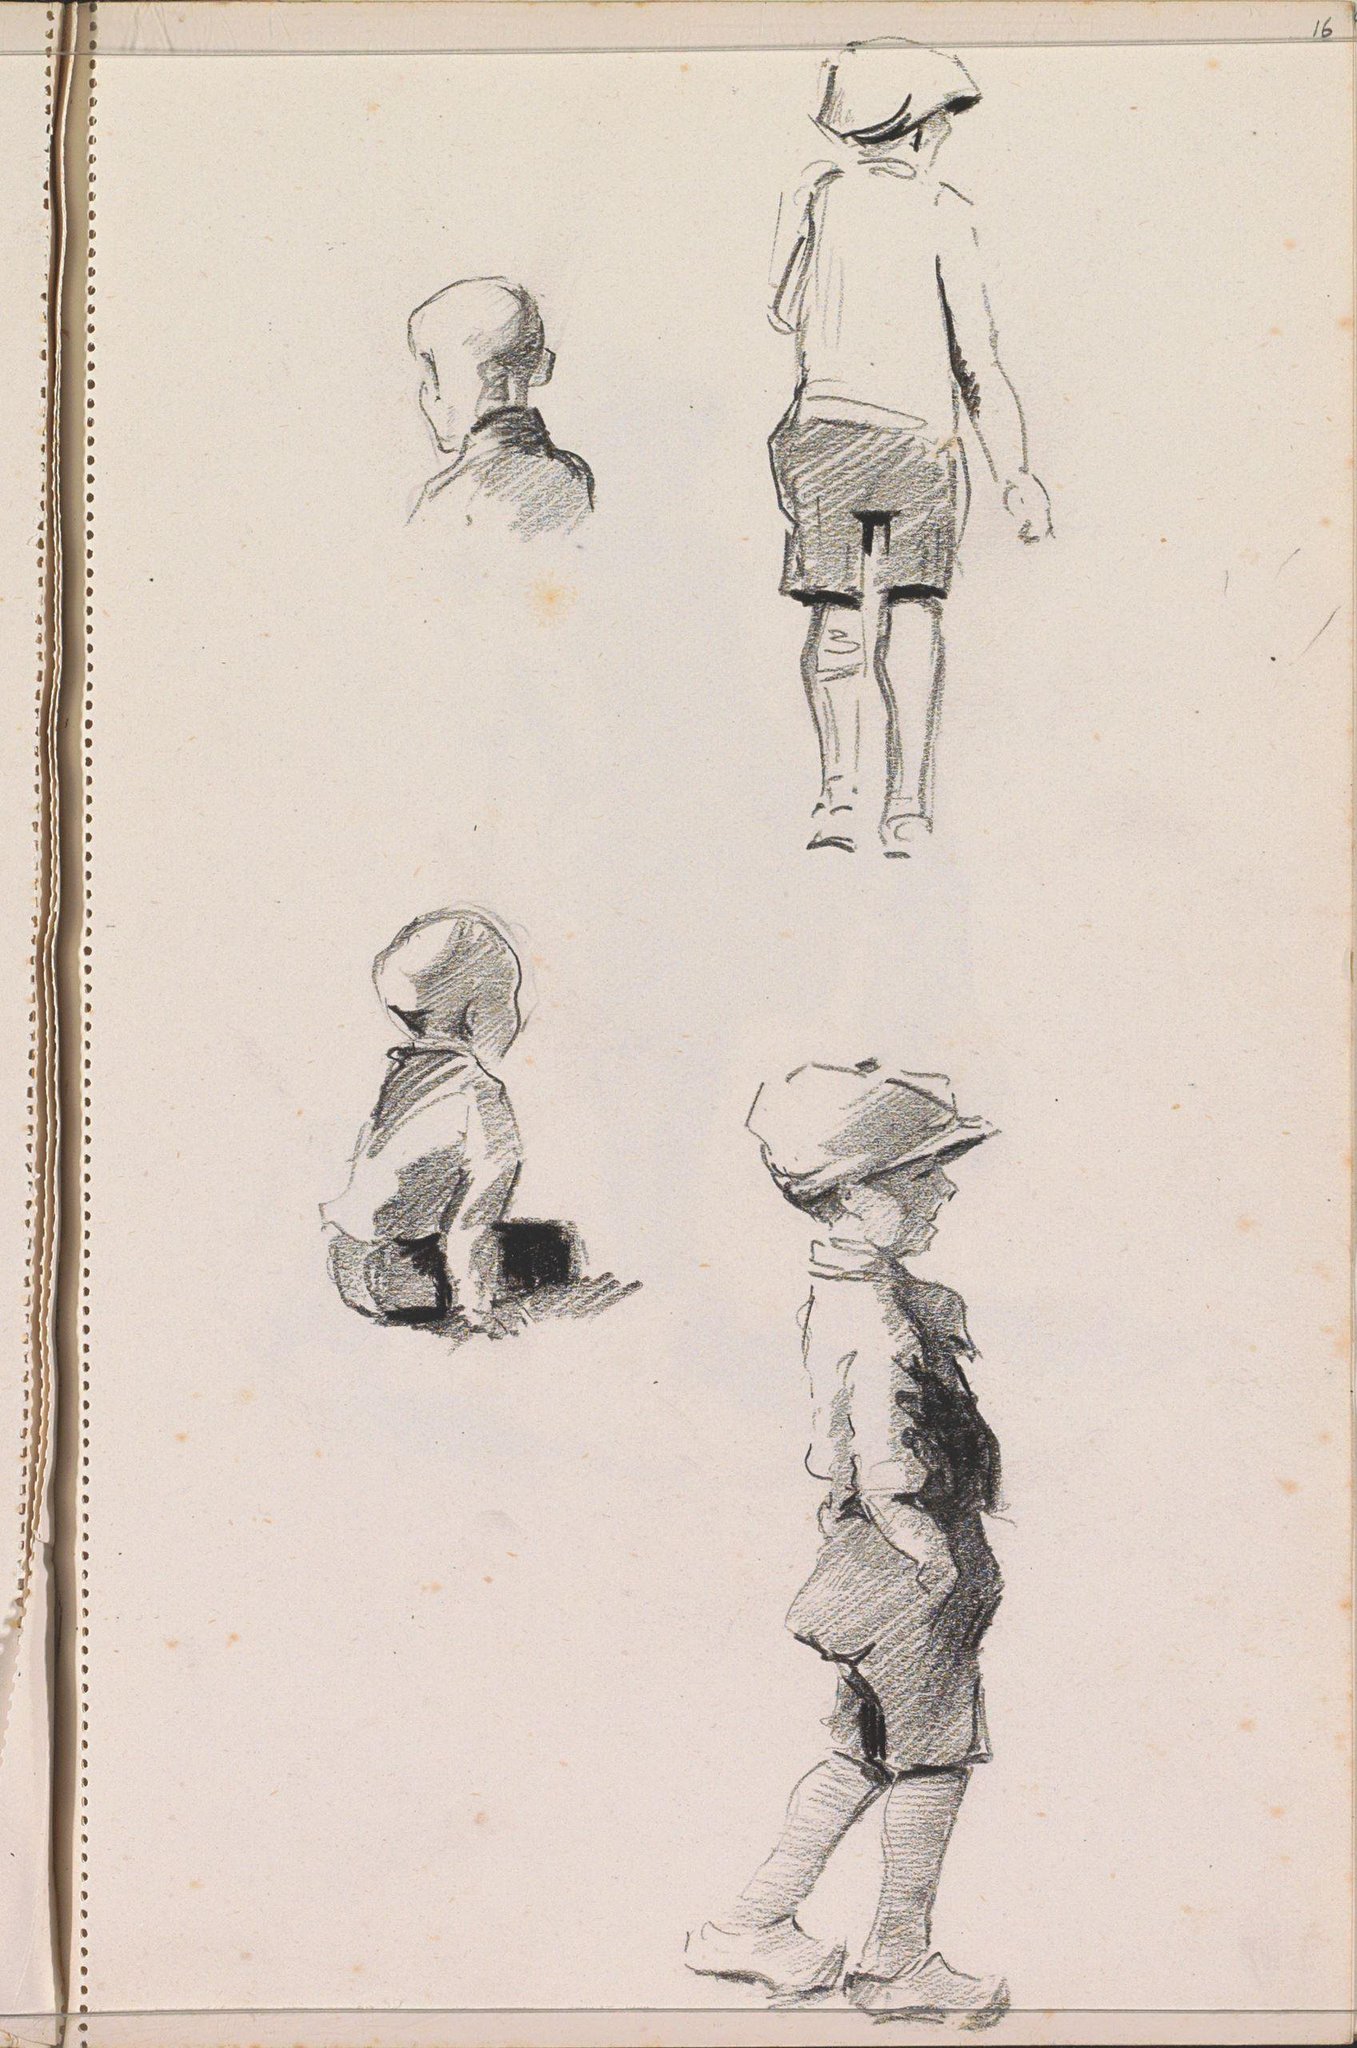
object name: sketchbook leaf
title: Jongen op klompen en een zittende peuter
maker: otto verhagen (i)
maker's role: draughtsman, print maker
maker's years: 1885-1951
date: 1922-1925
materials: chalk, paper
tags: boy (child between toddler and youth), wooden shoes, clogs, toddler (male)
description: Pagina 16 uit een schetsboek met 34 bladen.